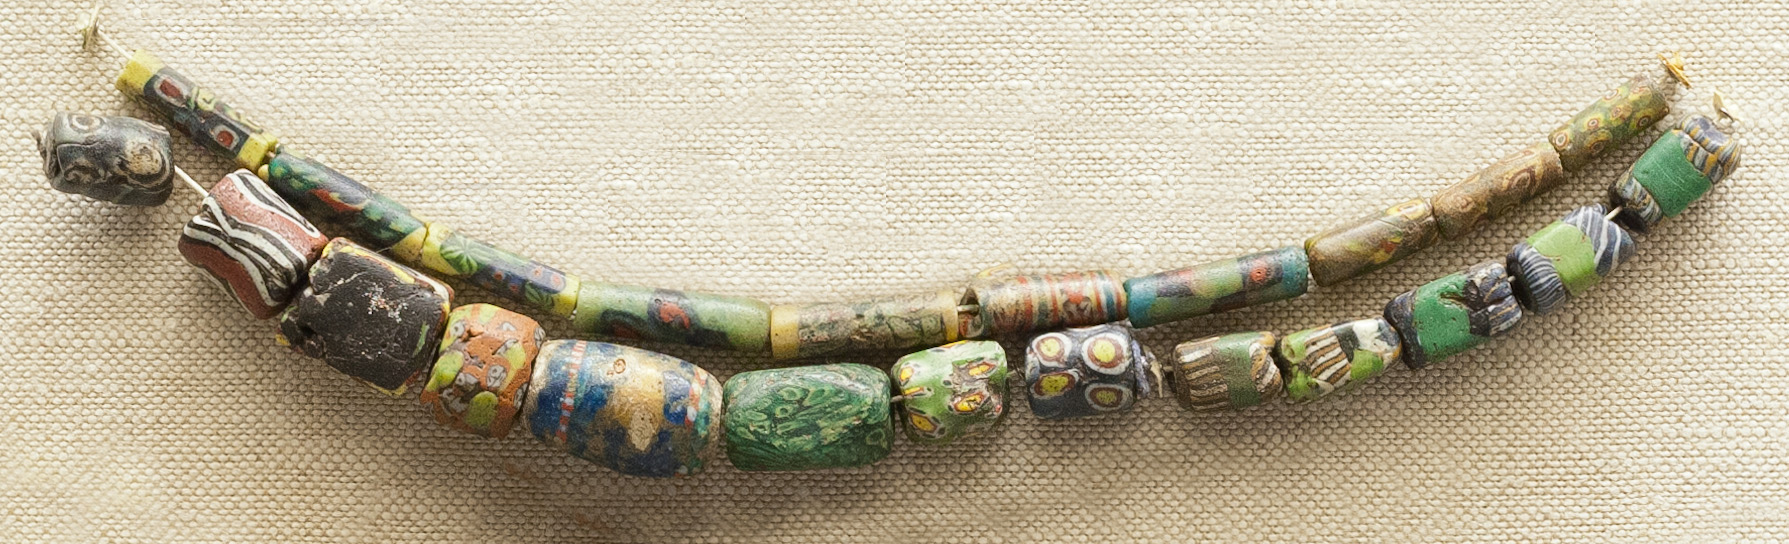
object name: bead, rectangular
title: String of 5 Beads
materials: glass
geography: egypt